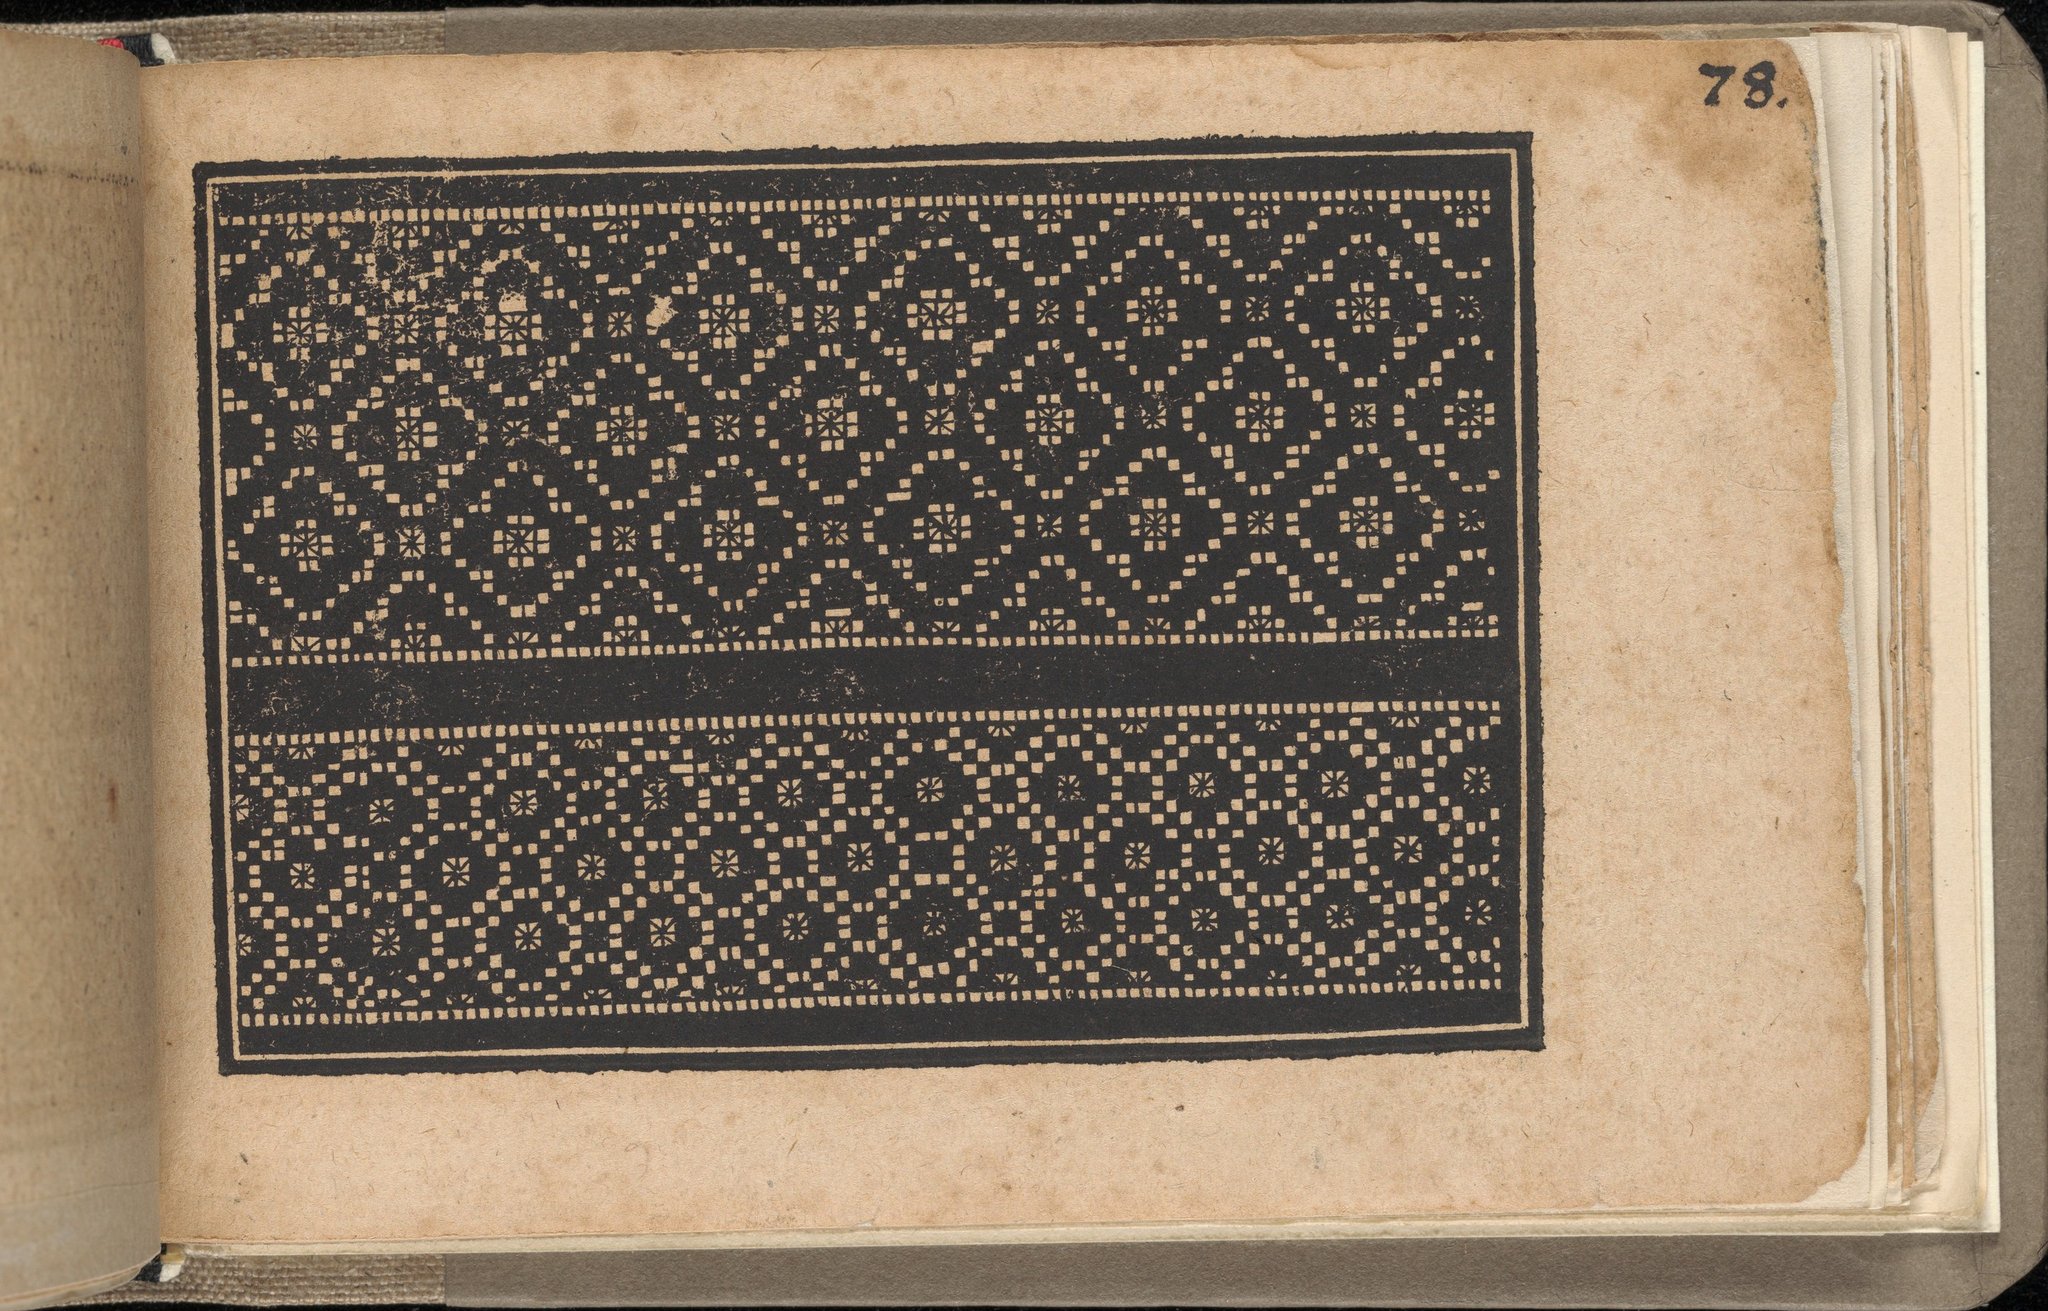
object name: book print ornament architecture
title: Schön newes Modelbuch (Page 78r)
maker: sigismundus latomus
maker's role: publisher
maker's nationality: german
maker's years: 1599-1632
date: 1608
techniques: woodcut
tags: ornament